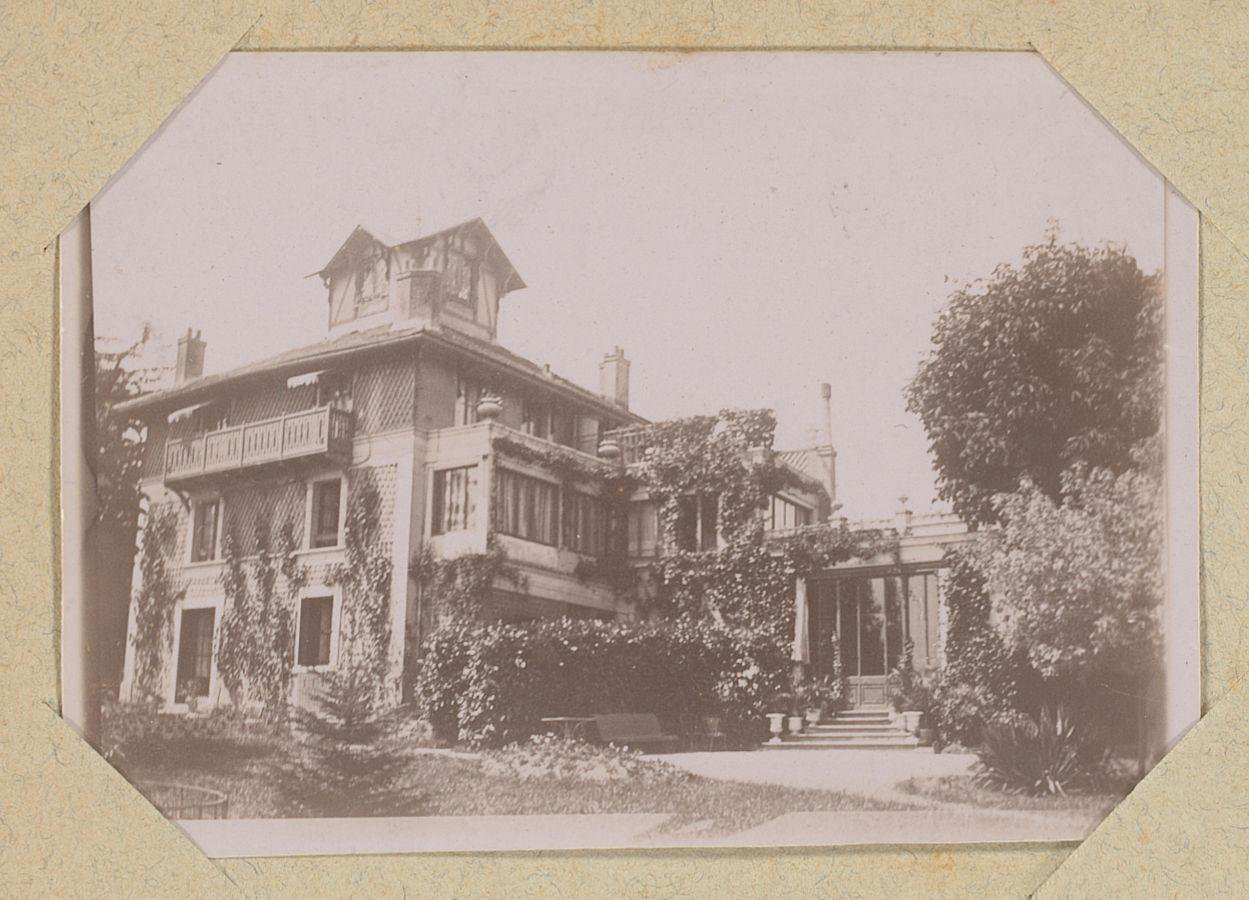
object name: photograph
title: Villa met omliggende tuin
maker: Anonymous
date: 1895-1900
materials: paper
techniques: gelatin silver print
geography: france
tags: villa, france